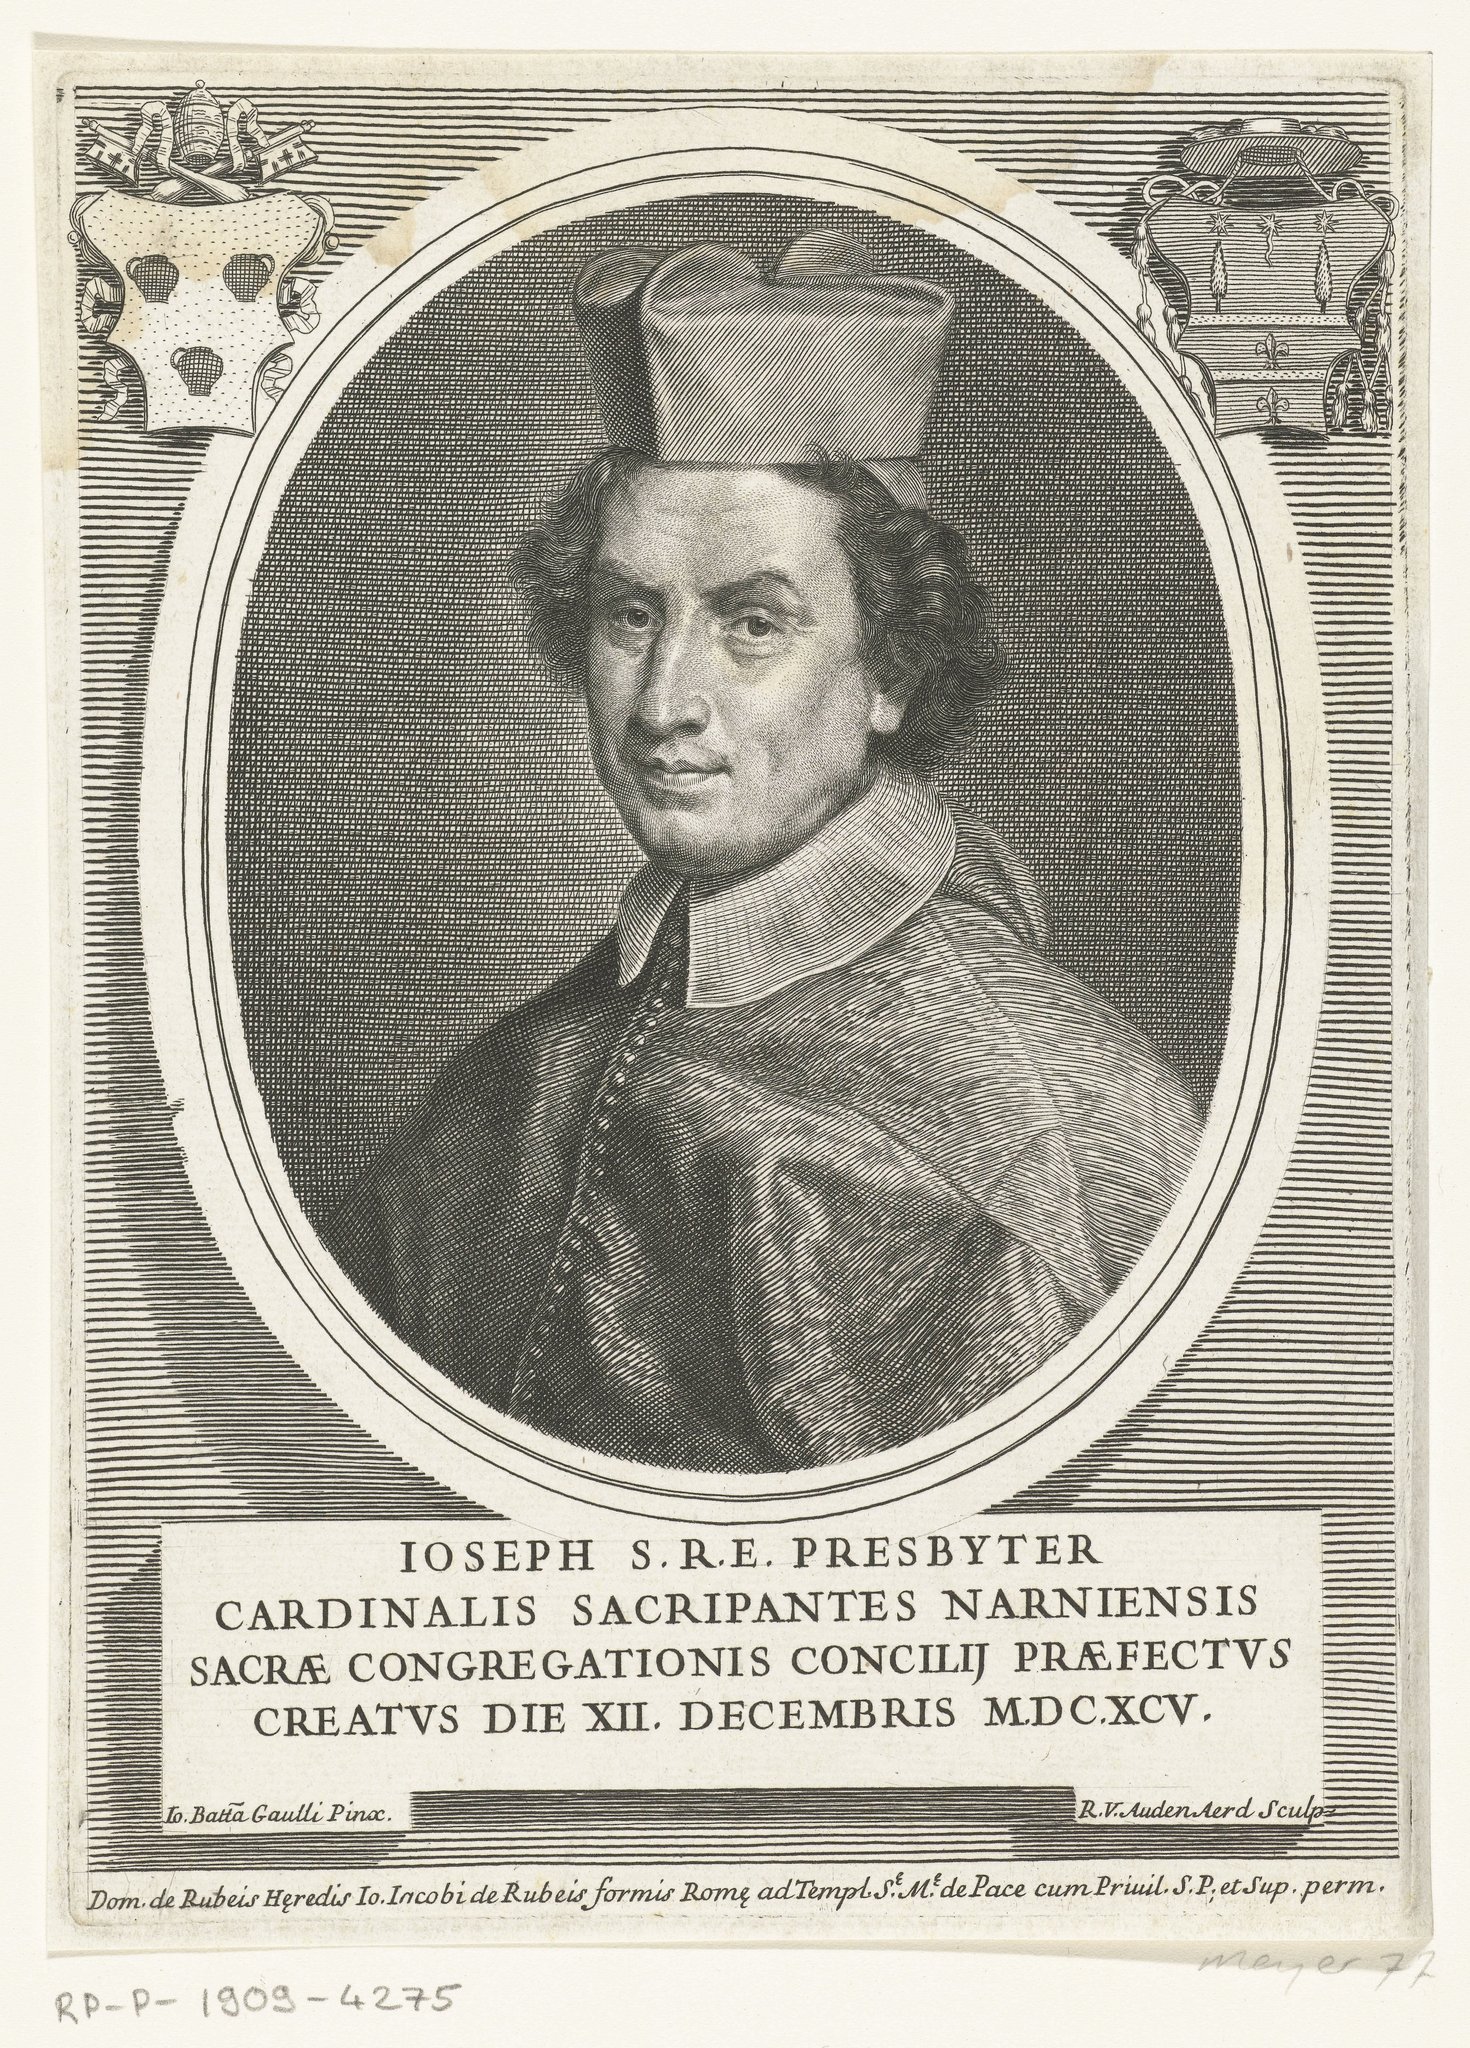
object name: print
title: Portret van kardinaal Giuseppe Sacripante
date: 1695-1723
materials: paper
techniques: engraving, etching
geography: rome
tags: rome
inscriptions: collector's mark: Lugt 2228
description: Borstbeeld van kardinaal Giuseppe Sacripante op 53 jarige leeftijd, gemaakt ter gelegenheid van zijn inwijding als kardinaal. In de bovenhoeken links het pauselijk wapen van Innocentius XII, en rechts zijn eigen kardinaalswapen. Onder het portret zijn naam en titels.